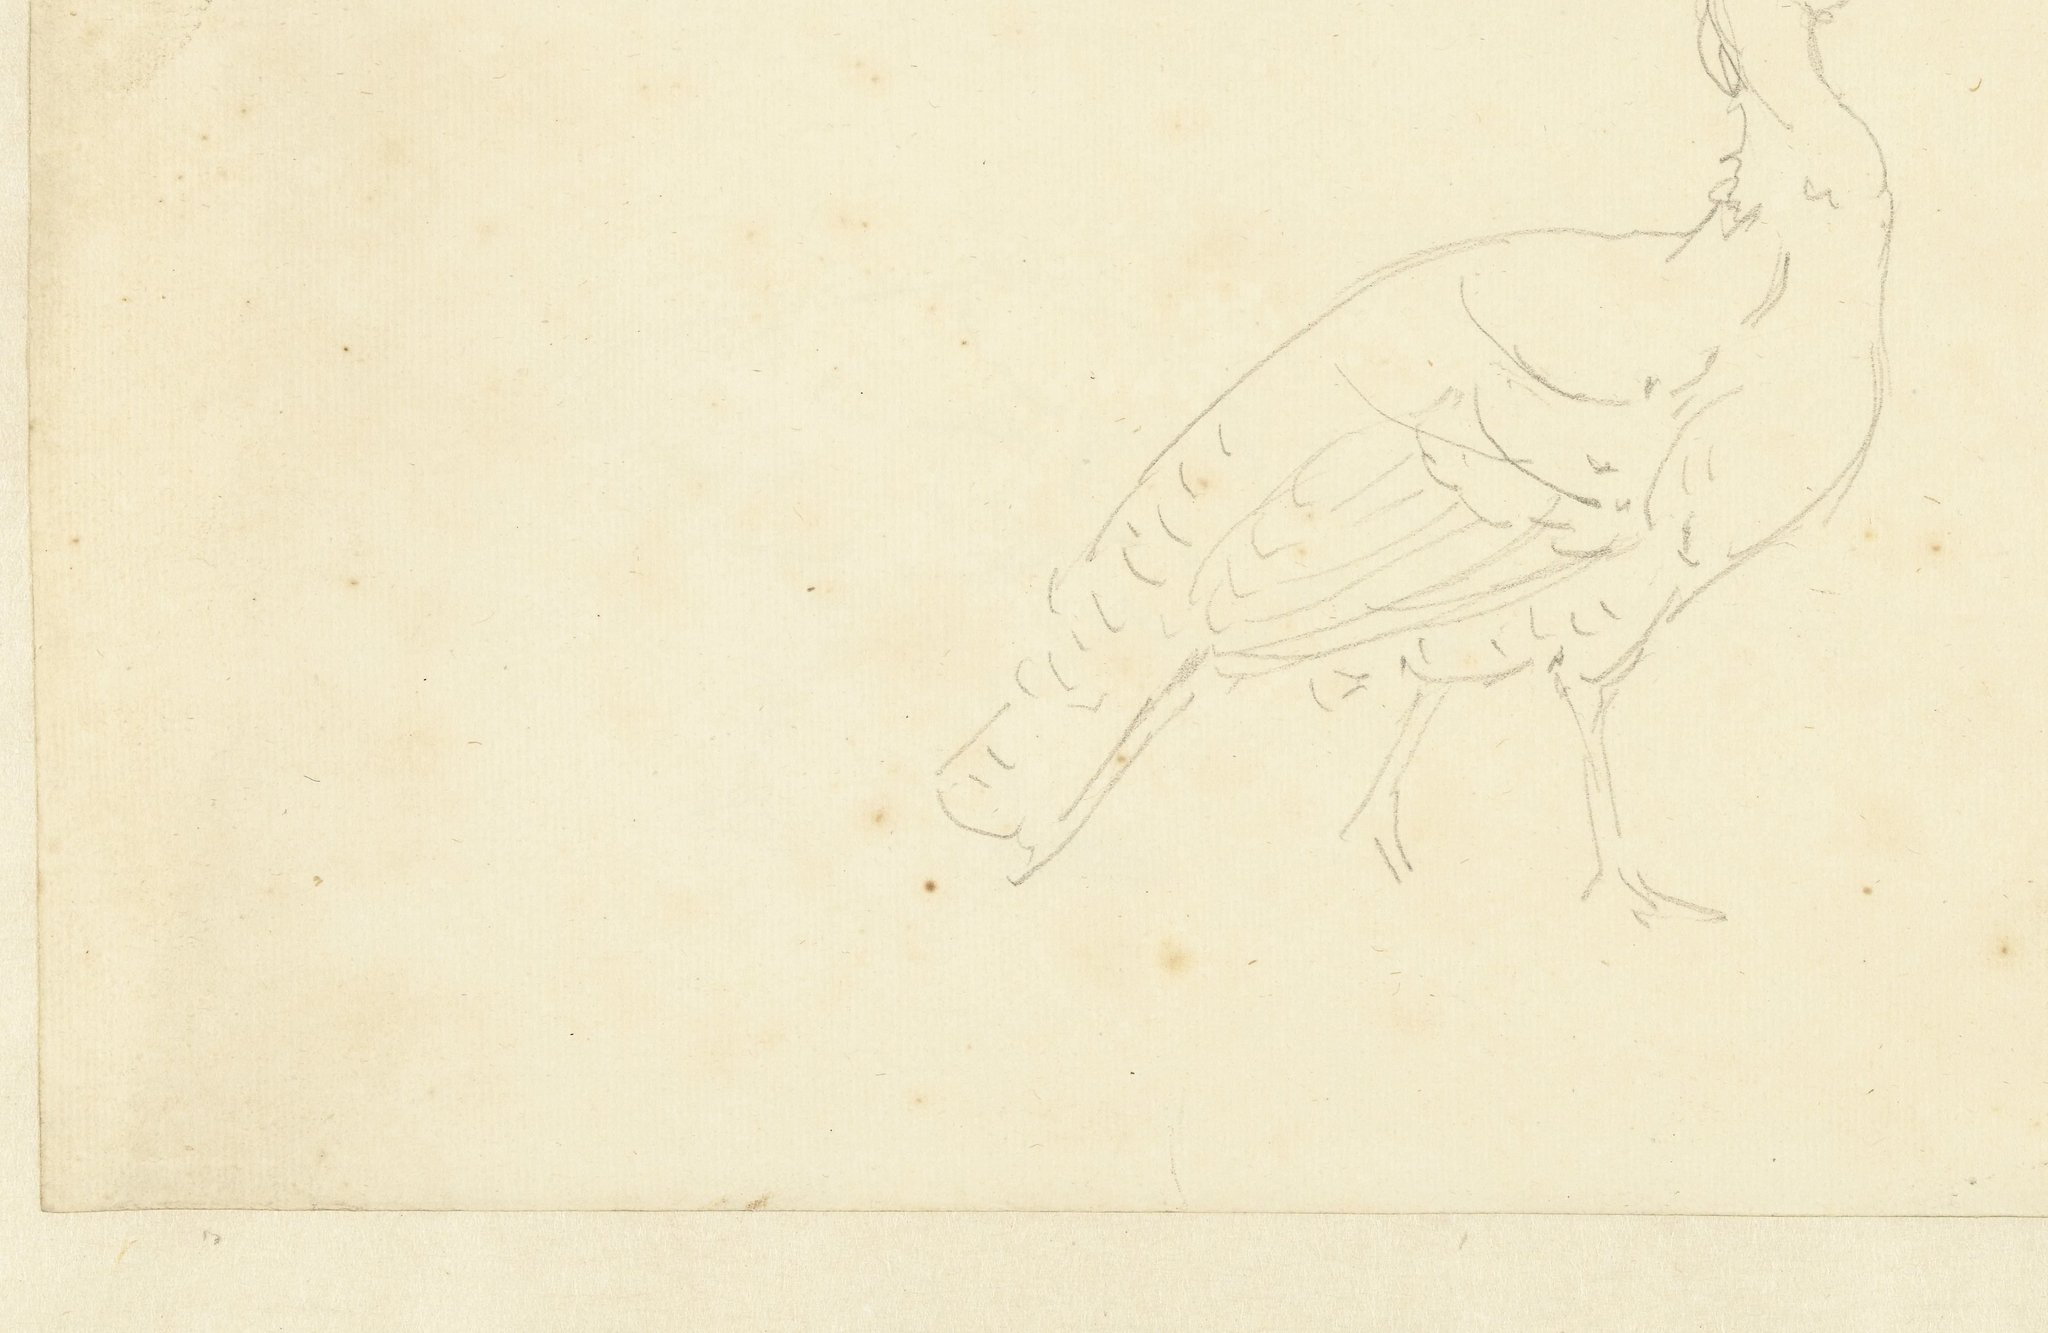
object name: drawing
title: Studie van een pauw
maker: aert schouman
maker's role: draughtsman, painter, print maker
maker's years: 1710-1792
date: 1720-1792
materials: paper, pencil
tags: ornamental birds: peacock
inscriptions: inscription: ‘een pauw’